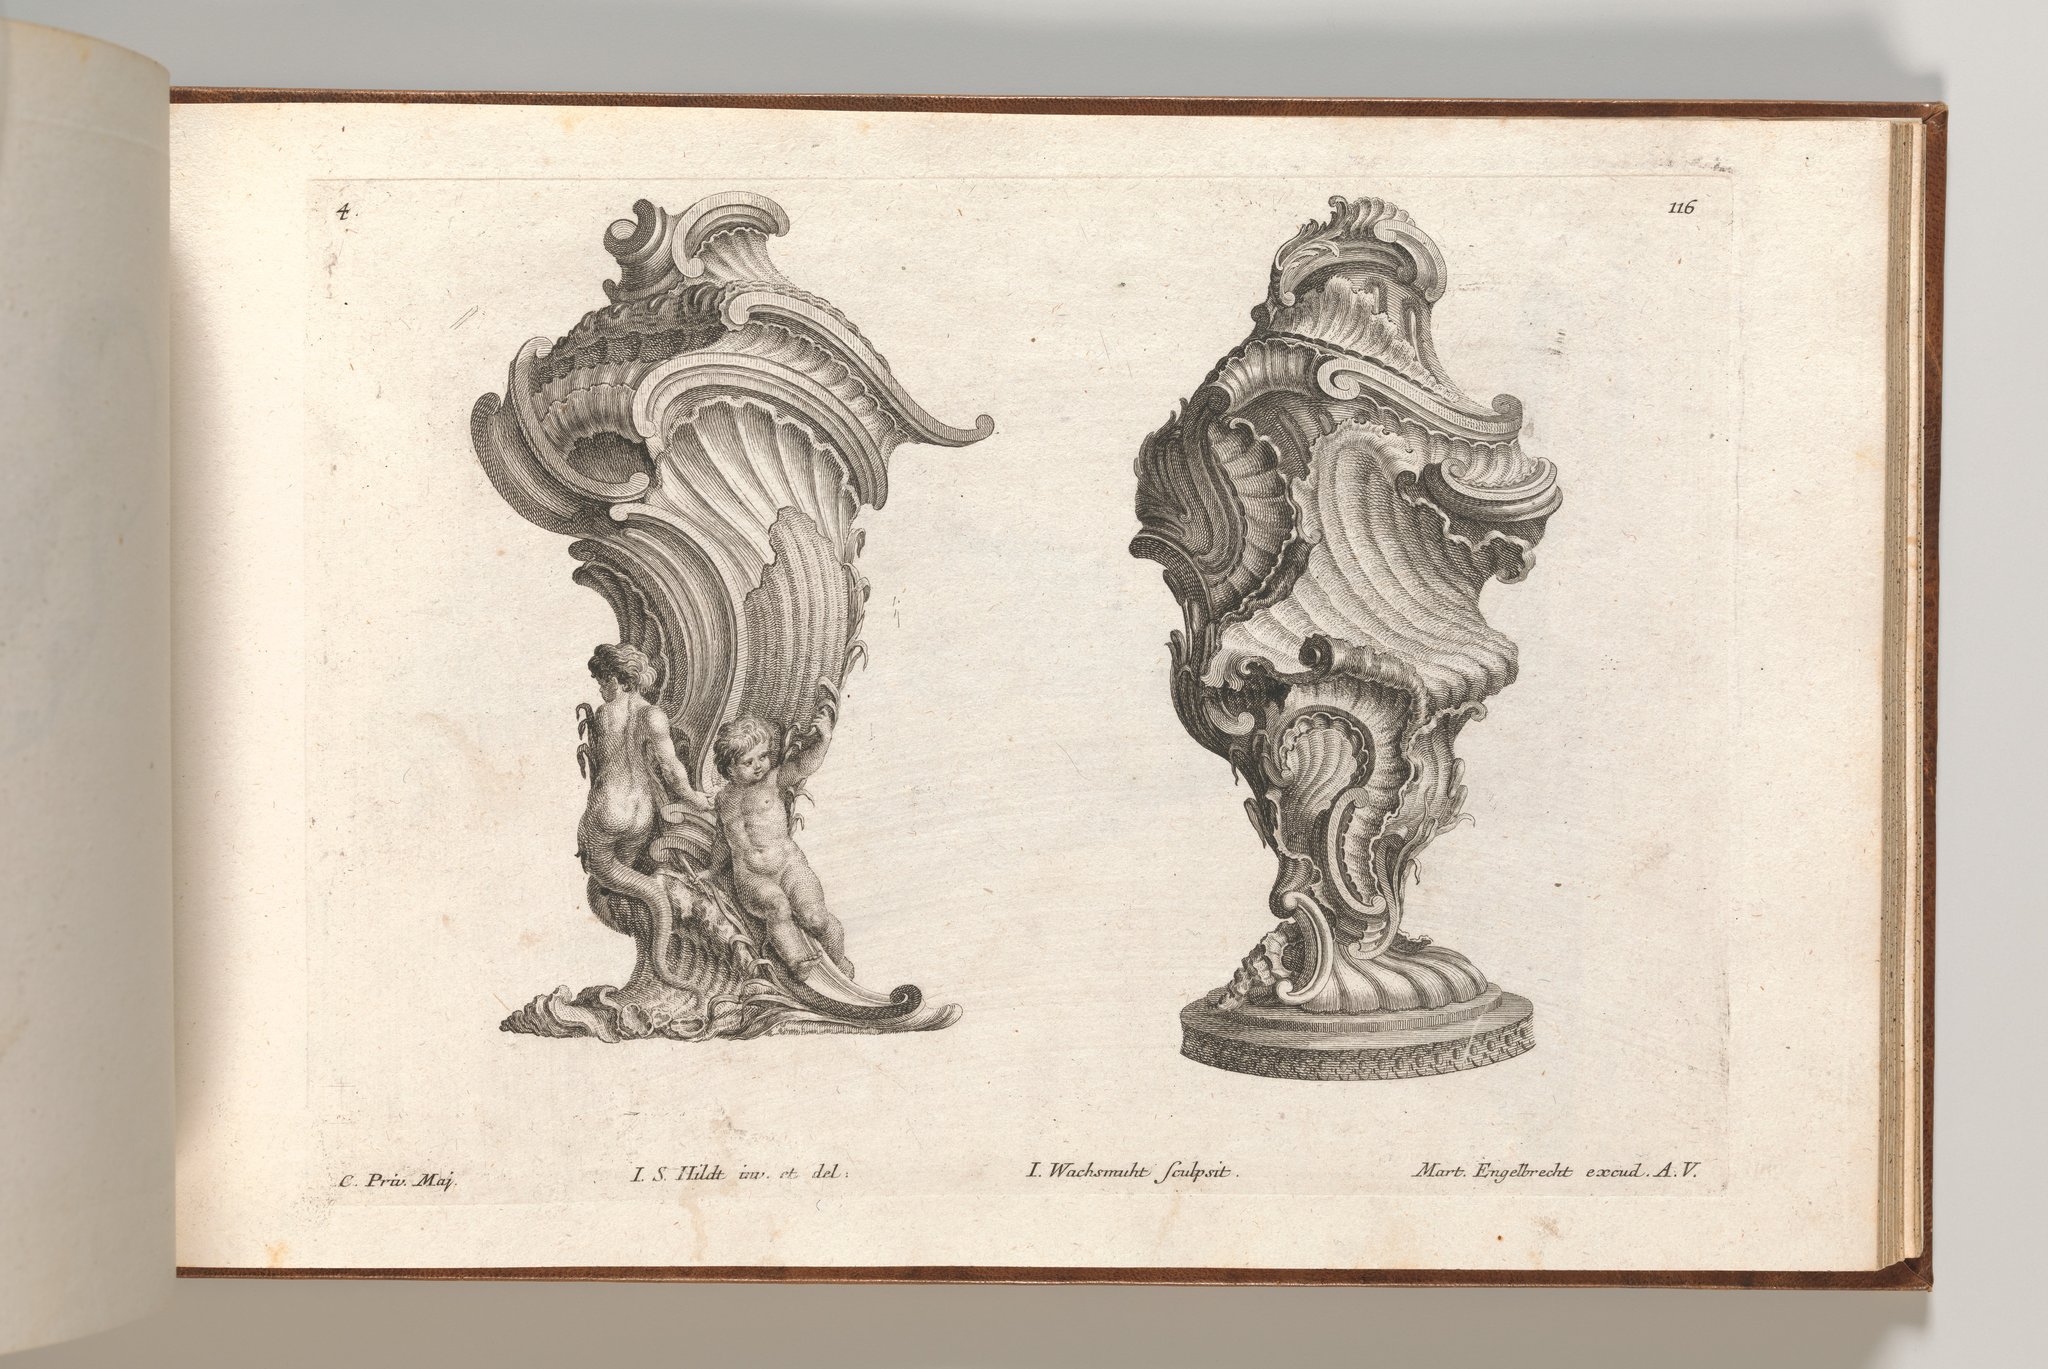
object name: album print ornament architecture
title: Designs for Two Lidded Vases, Plate 4 from: 'Schöne und auf die neueste Facon inventierte Gefäße und Krüge'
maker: i.s. hildt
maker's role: artist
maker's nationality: central european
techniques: etching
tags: ornament,putti,vases